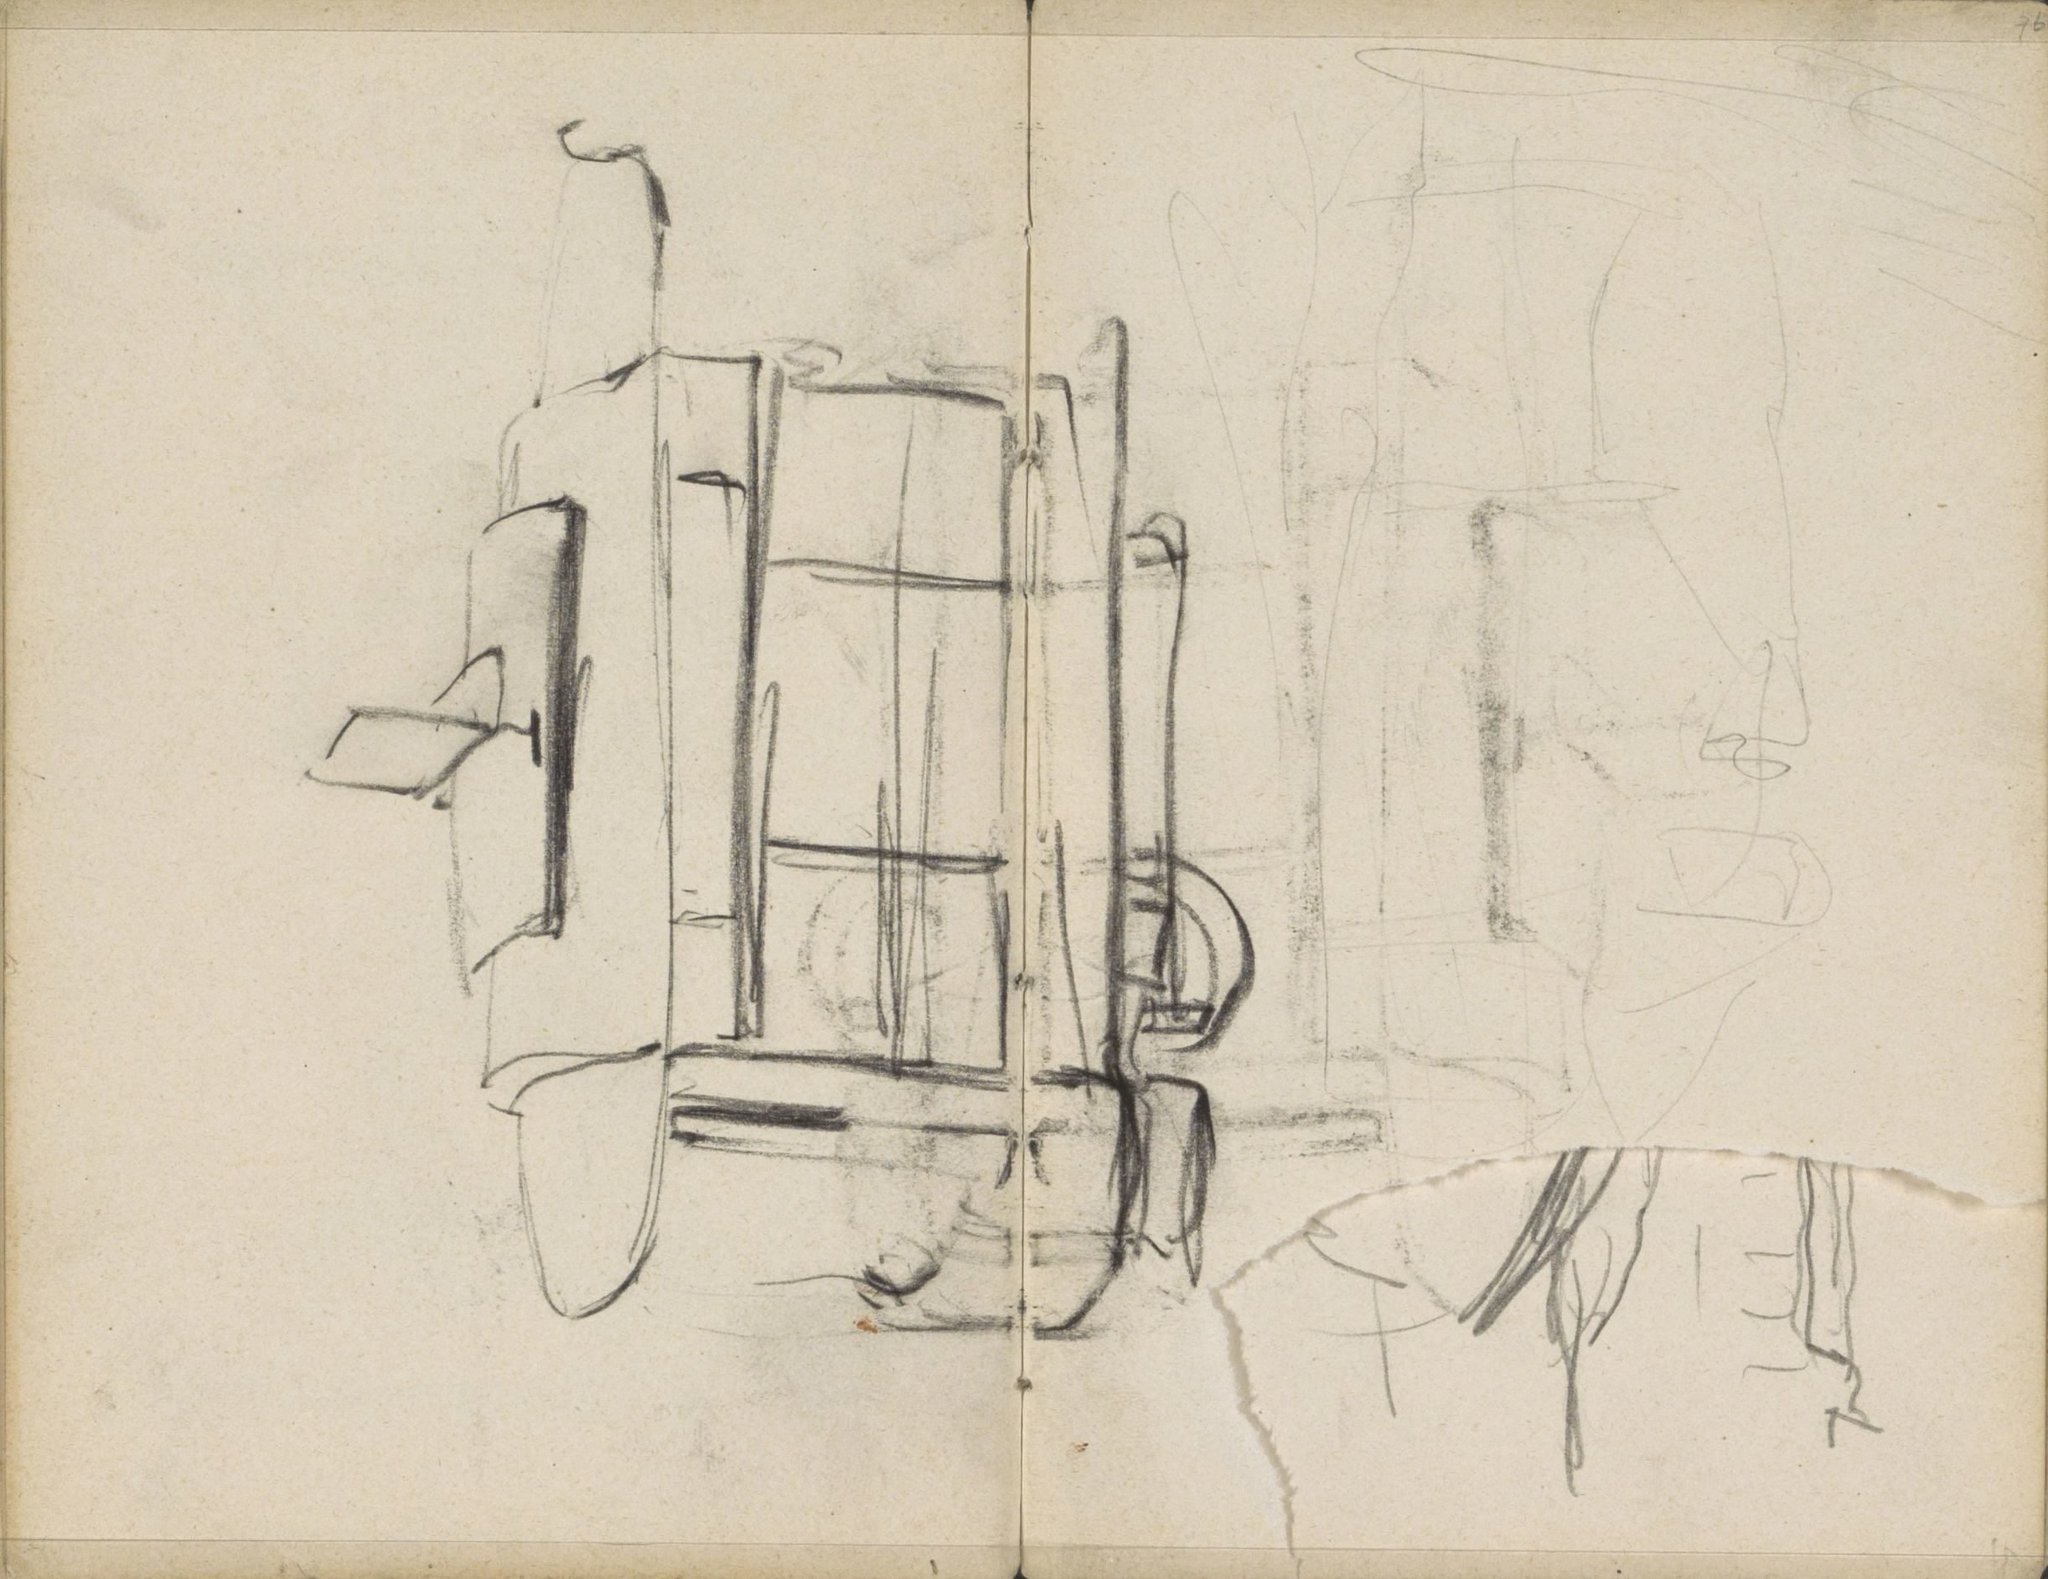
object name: sketchbook leaf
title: Studie, mogelijk van een raam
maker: george hendrik breitner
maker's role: draughtsman, painter, print maker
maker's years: 1857-1923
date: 1903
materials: chalk, paper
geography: amsterdam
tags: window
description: Studie, mogelijk van een raam. Pagina 75 en pagina 76 uit een schetsboek met 46 bladen.